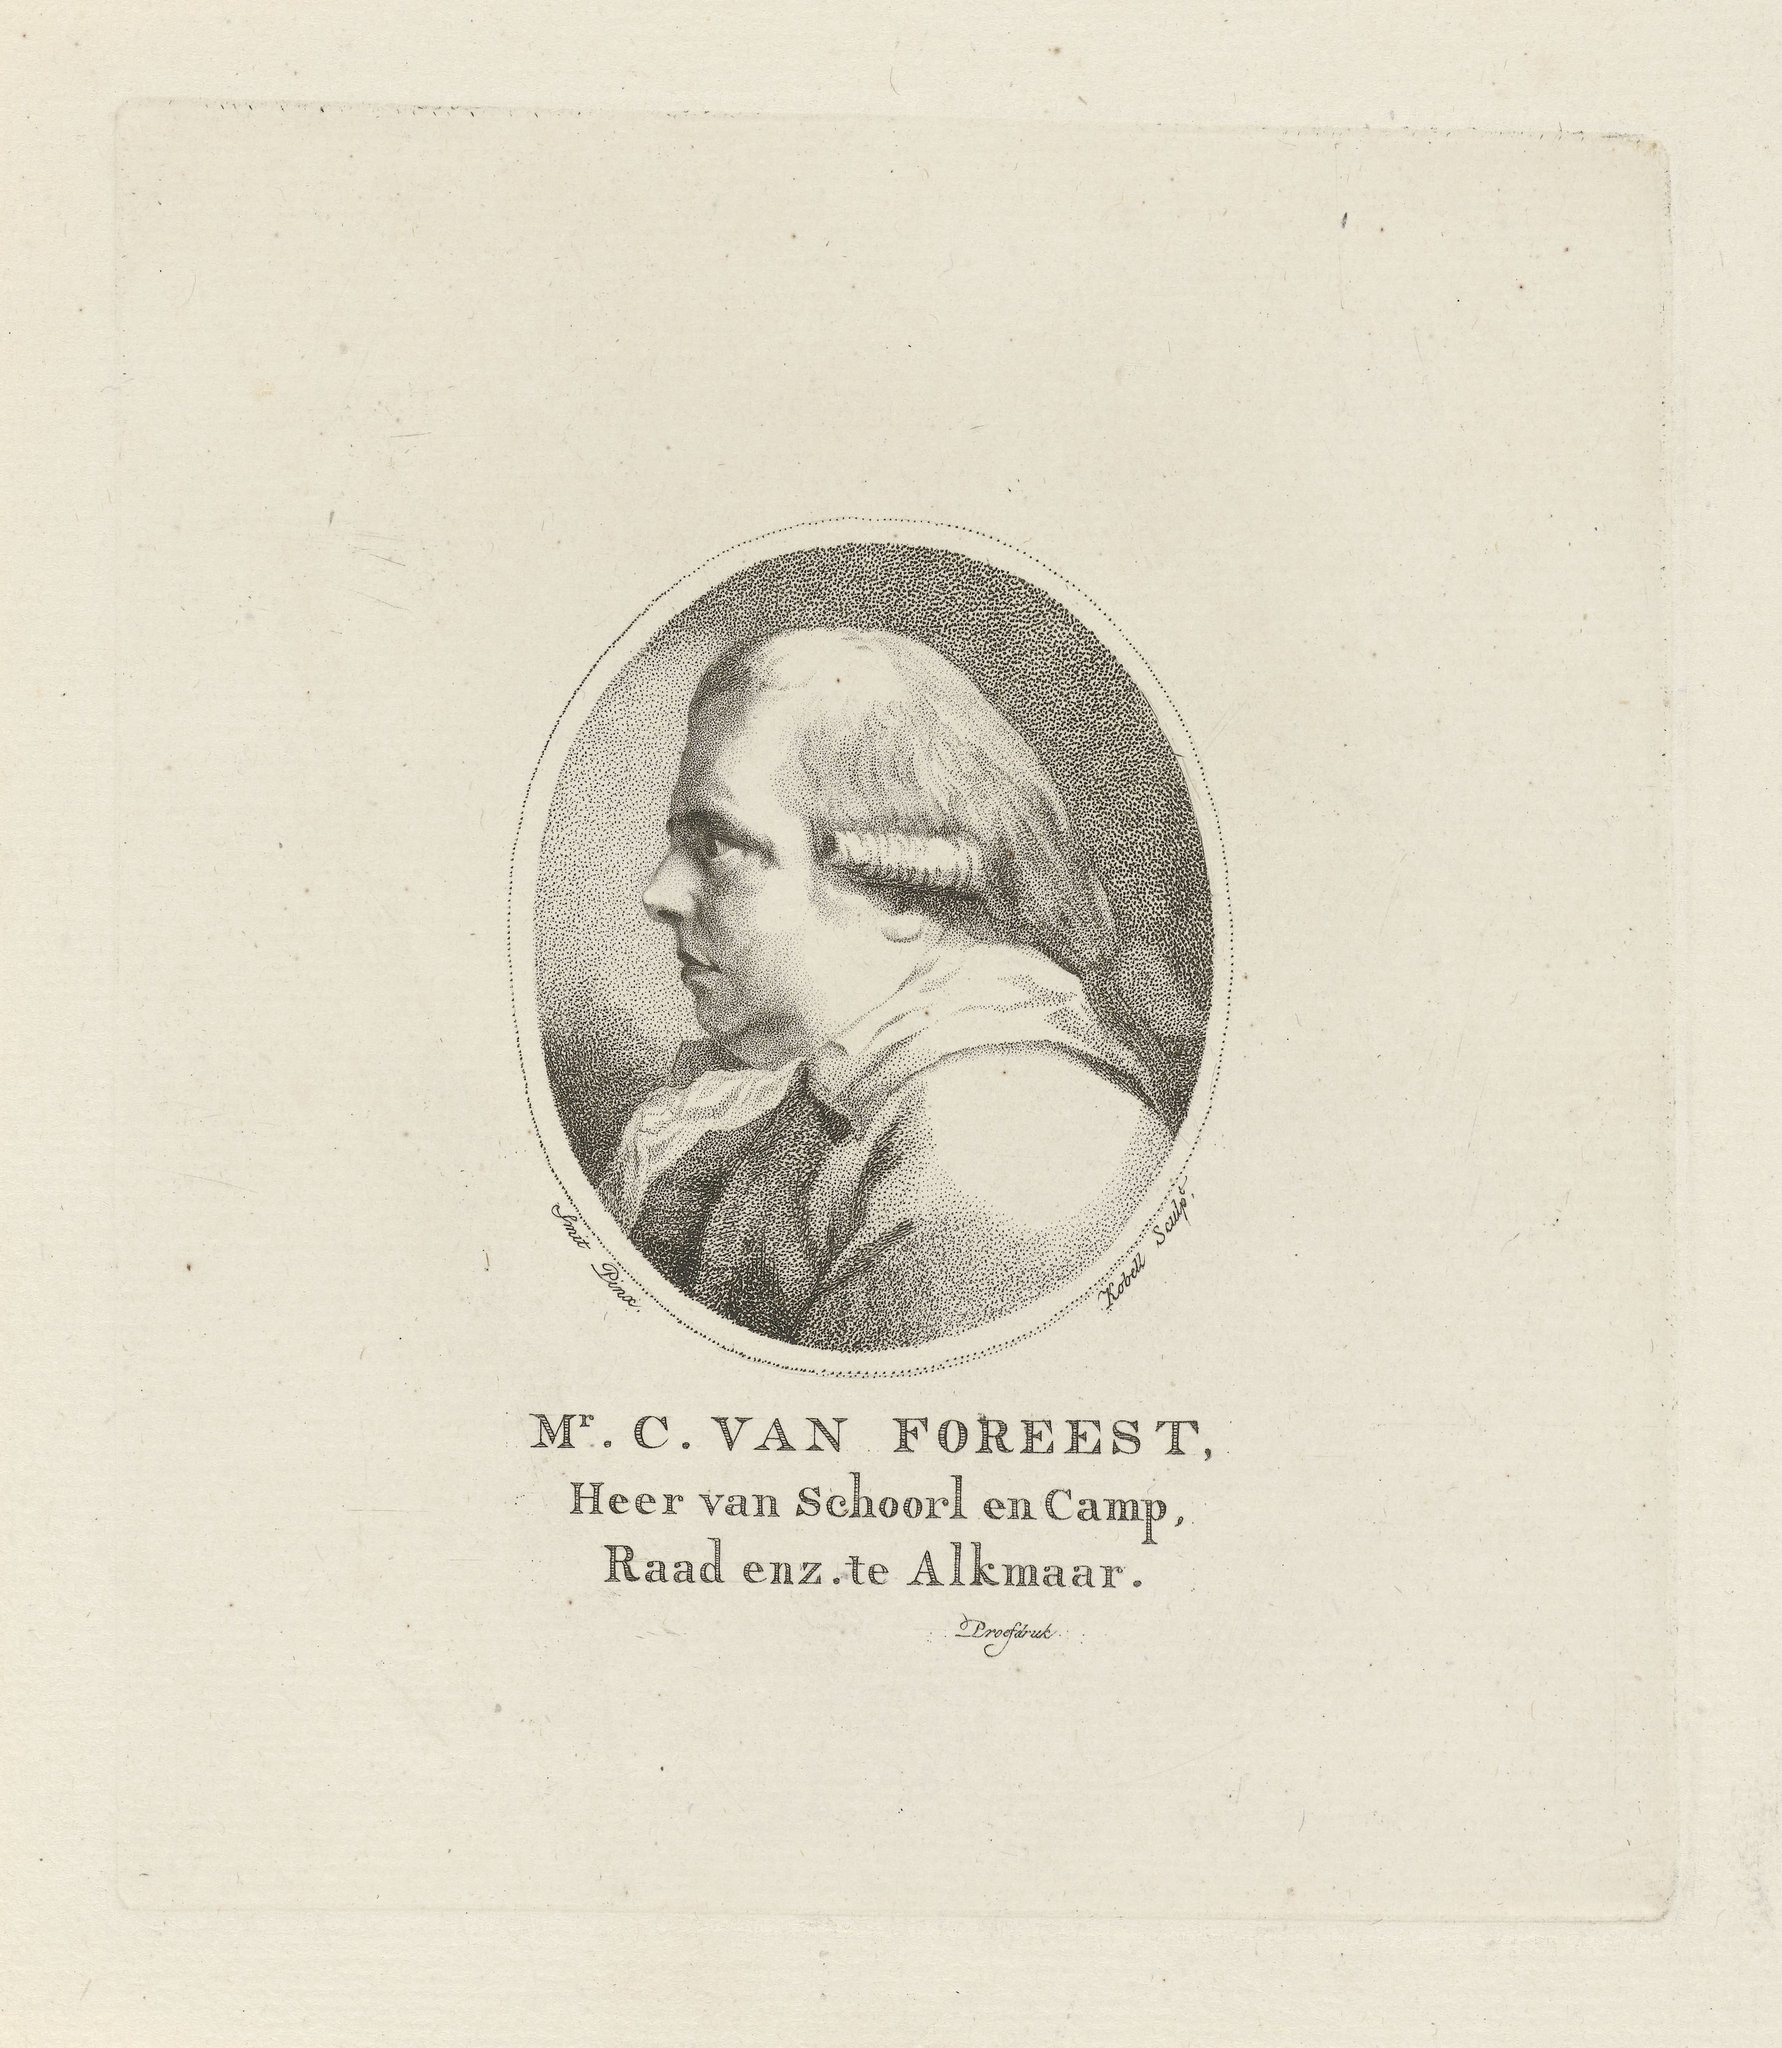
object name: print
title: Cornelis van Foreest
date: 1766-1833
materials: paper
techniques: etching, engraving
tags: wig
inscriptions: collector's mark: Lugt 2228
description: Portretbuste in profiel van Cornelis van Foreest, heer van Schoorl, Groet en Kamp. Hij draagt een staartpruik en een sjaal.